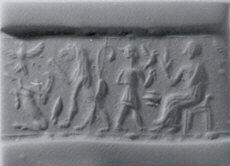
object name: cylinder seal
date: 1820-1730 BCE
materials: stone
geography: syria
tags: birds,lions